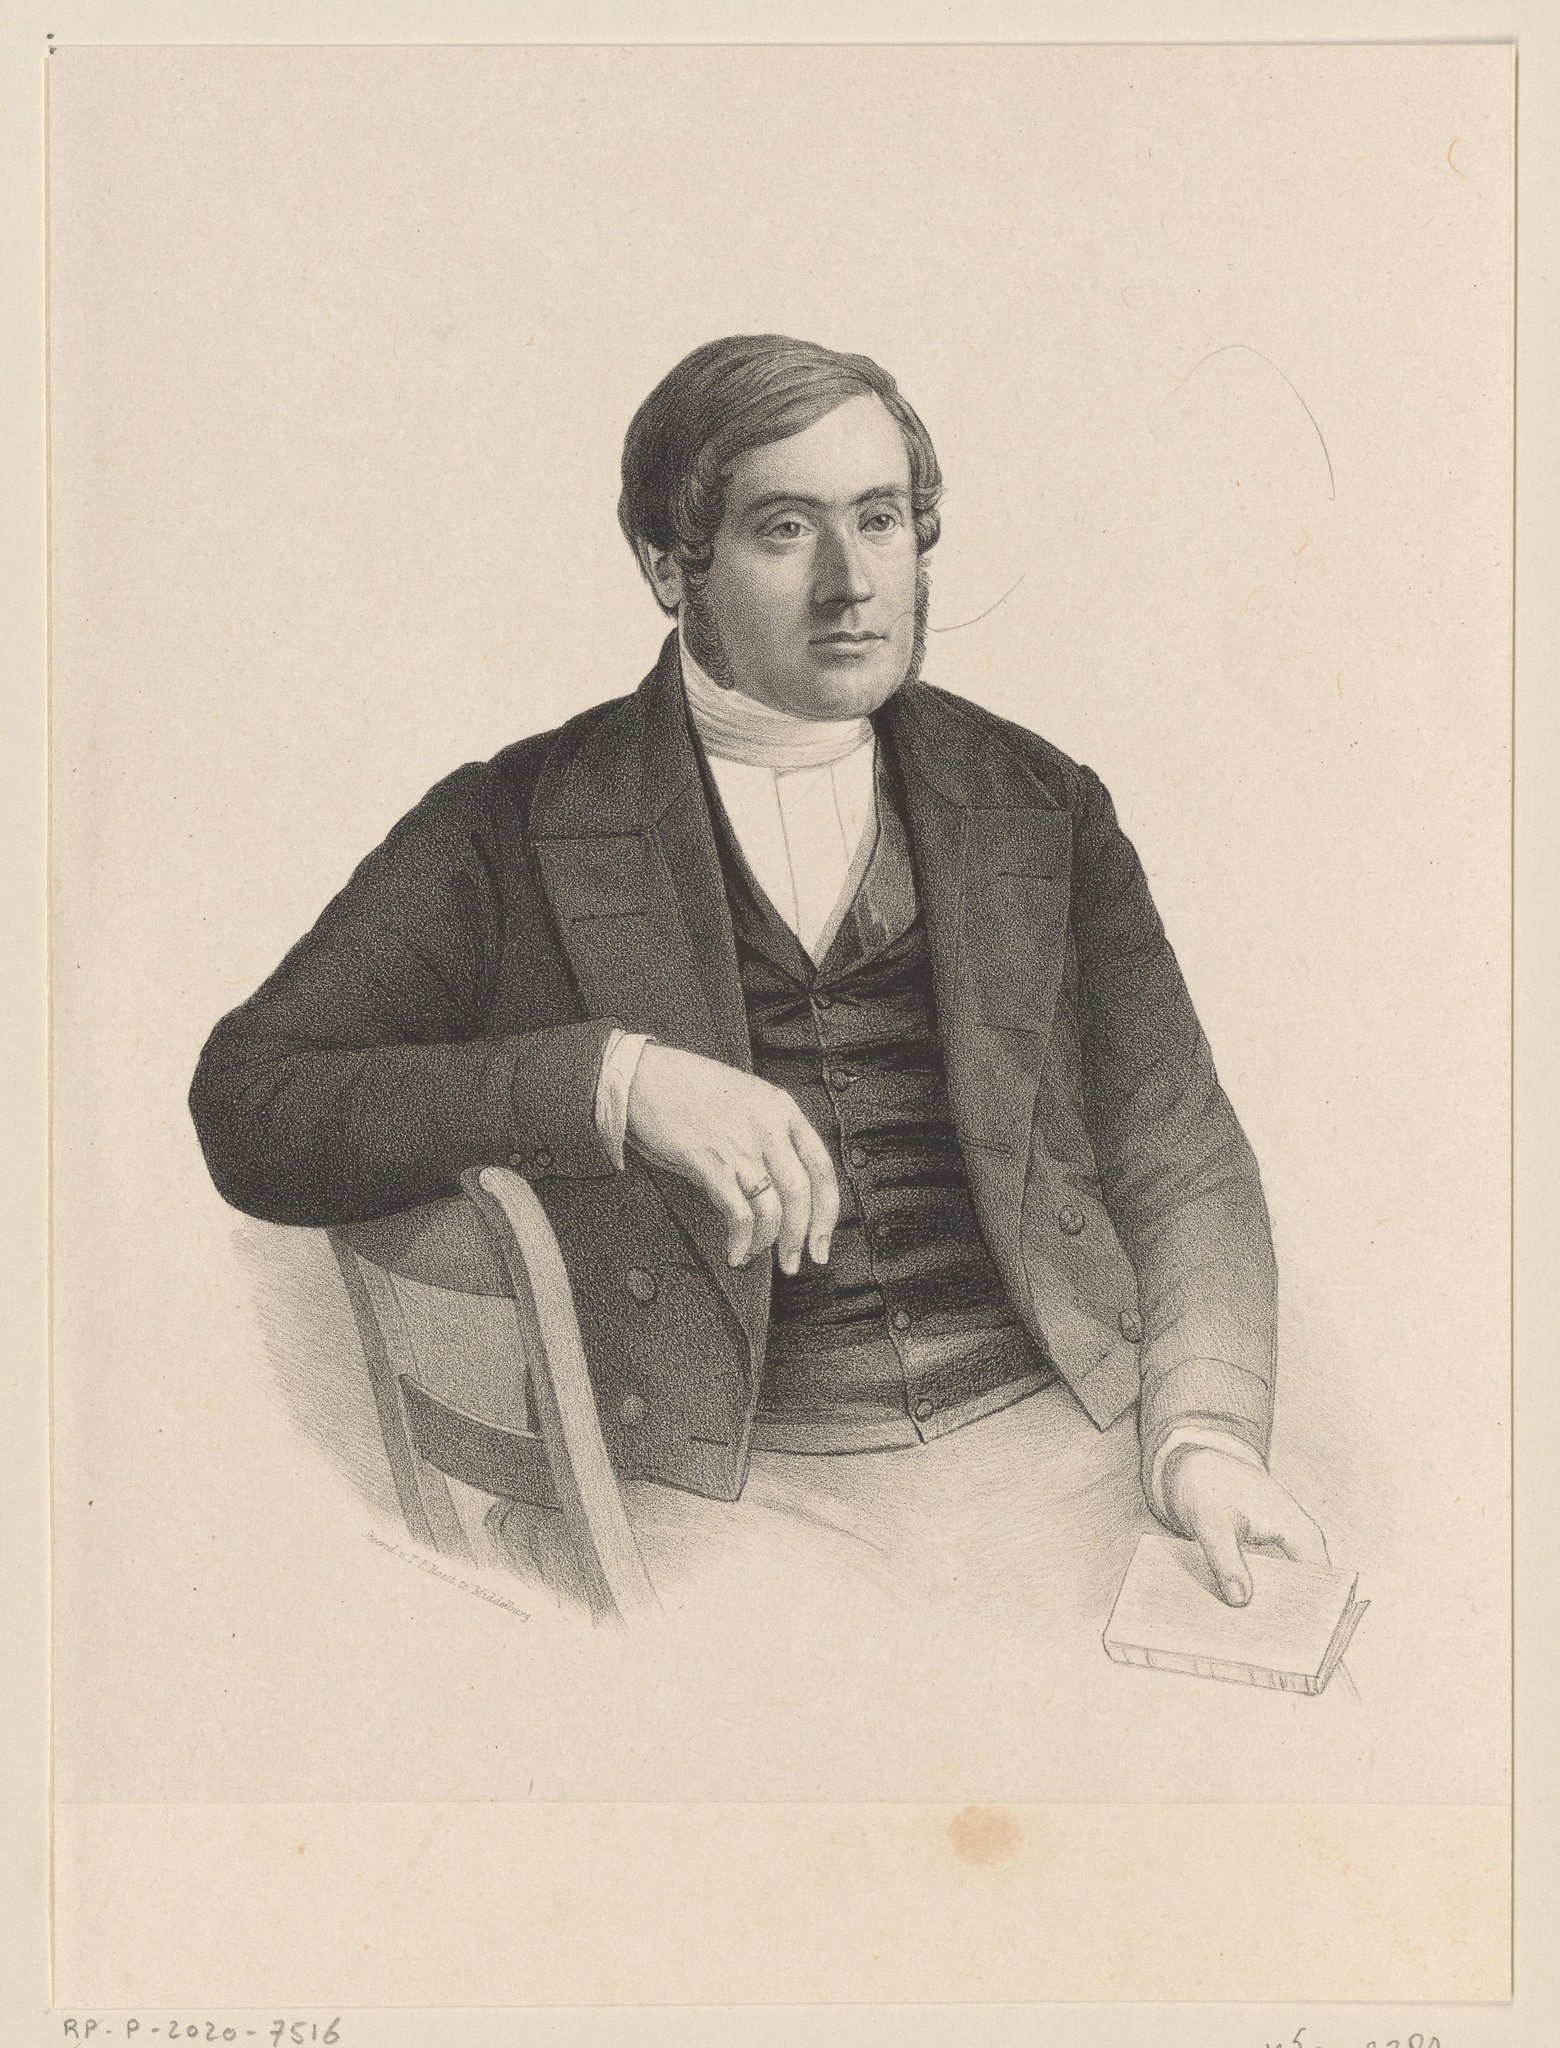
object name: print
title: Portret van Johannes Petrus Hasebroek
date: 1851-1888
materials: paper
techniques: lithograph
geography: middelburg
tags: leiden, amsterdam, historical persons, portrait of a writer, book